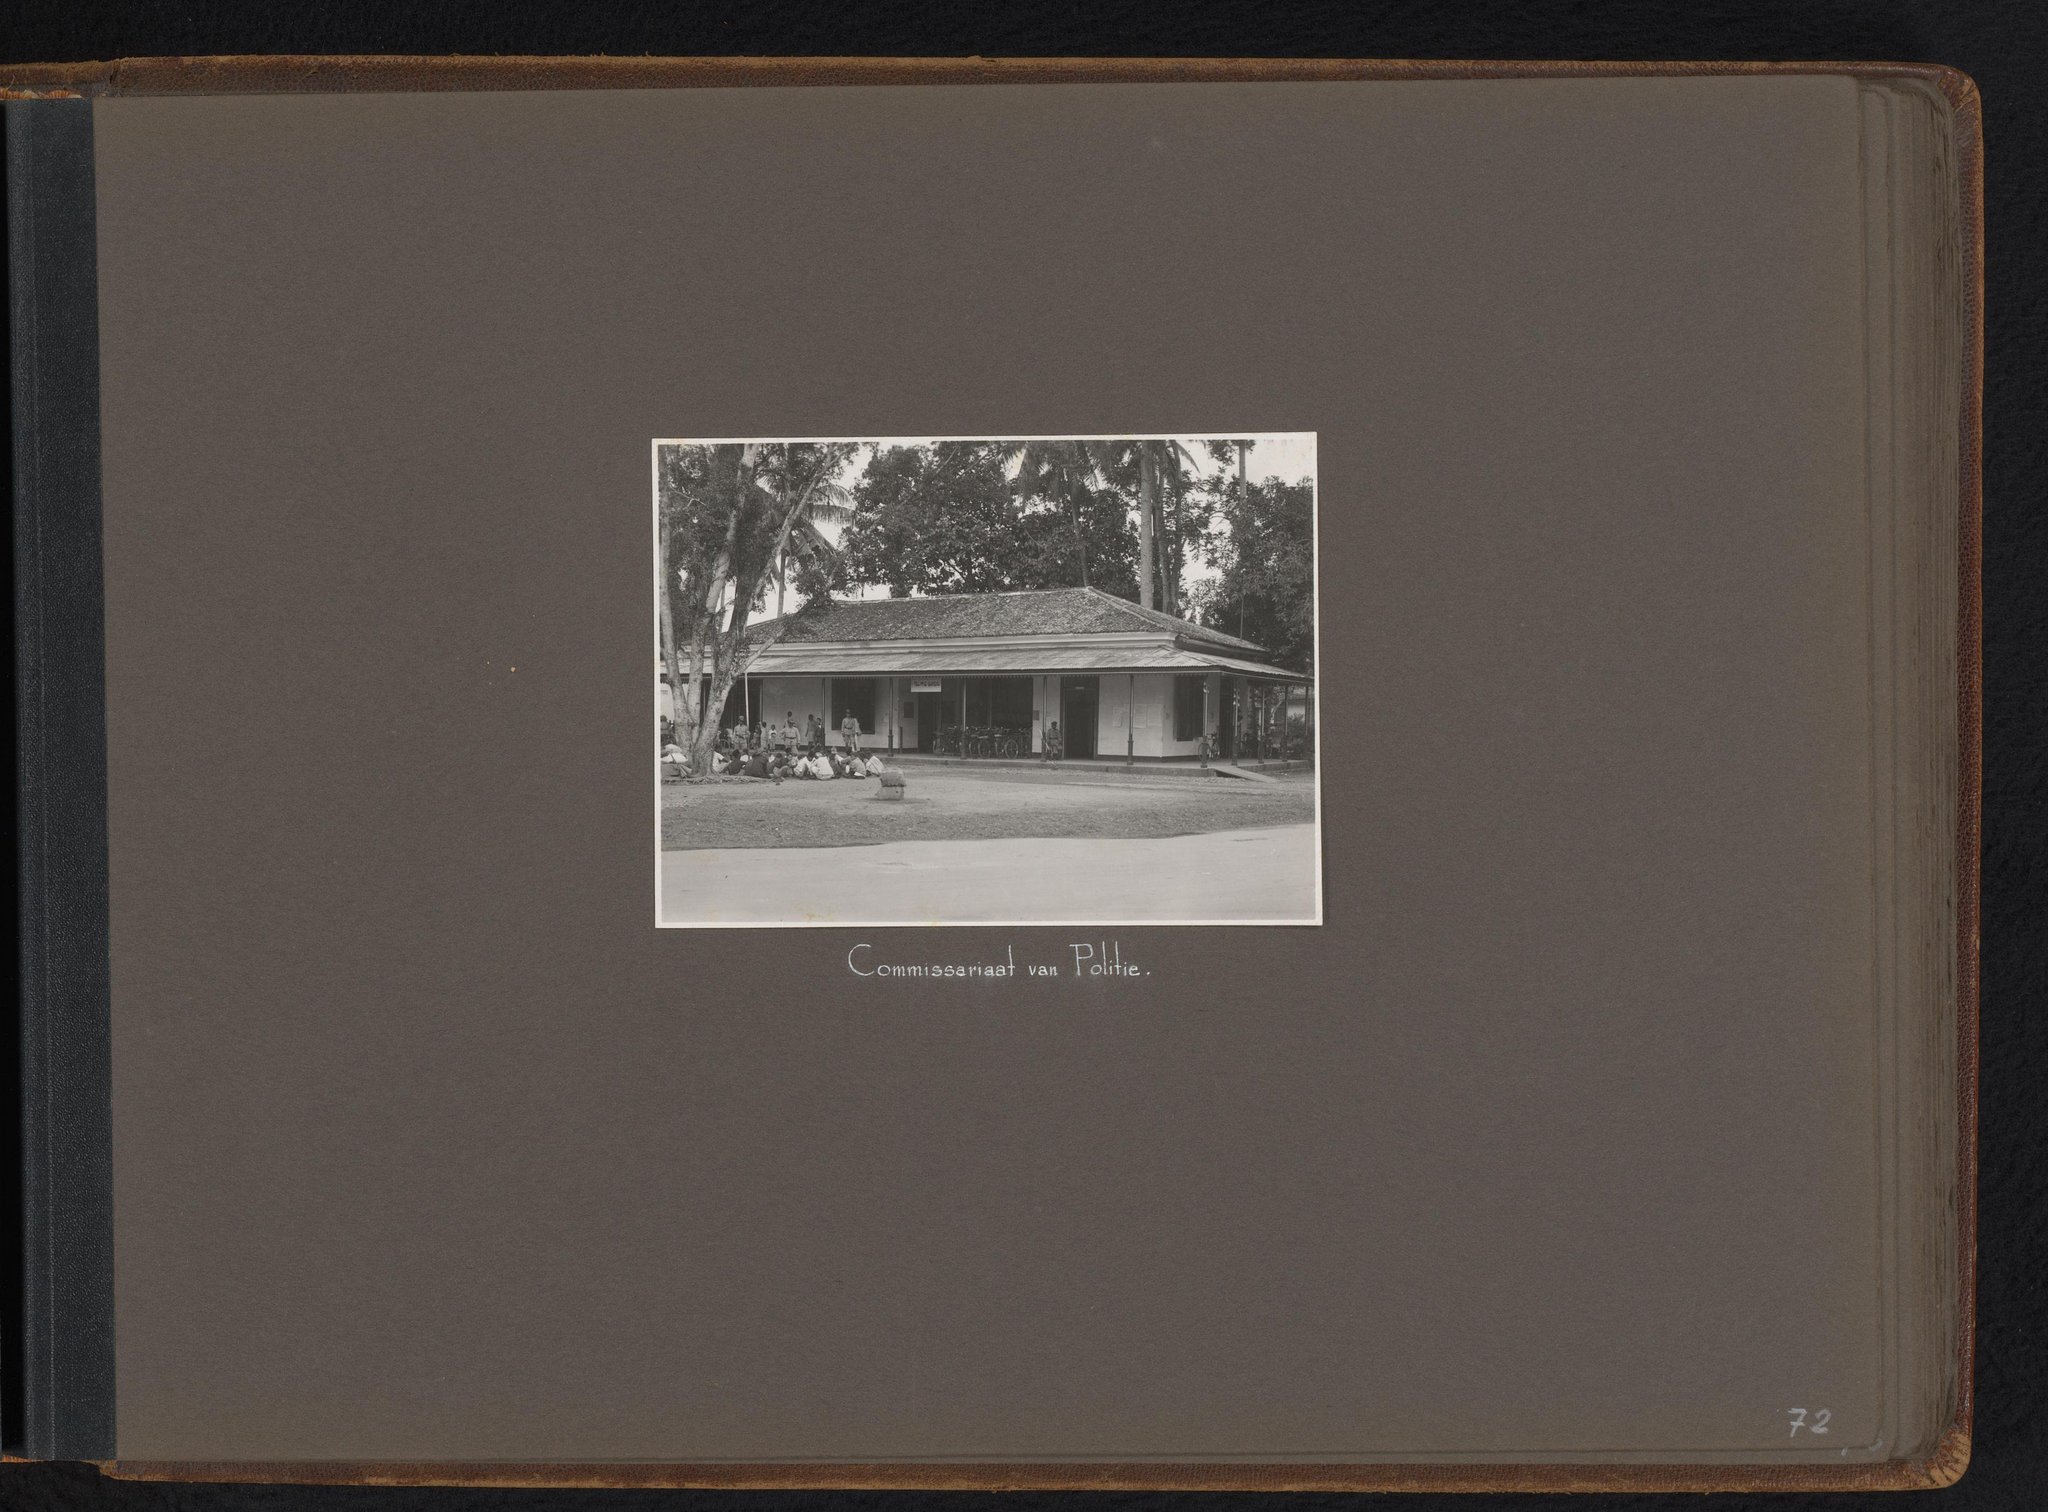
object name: album leaf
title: Commissariaat van Politie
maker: Anonymous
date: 1925-1931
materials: cardboard, photographic support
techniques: gelatin silver print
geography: medan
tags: sumatra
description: Albumblad met één foto: gebouw van het Commissariaat van Politie te Medan. Onderdeel van het fotoalbum aangeboden aan S. Koster door de Vereeniging van Hoogere Politie Ambtenaren in Nederlandsch-Indië in 1931.